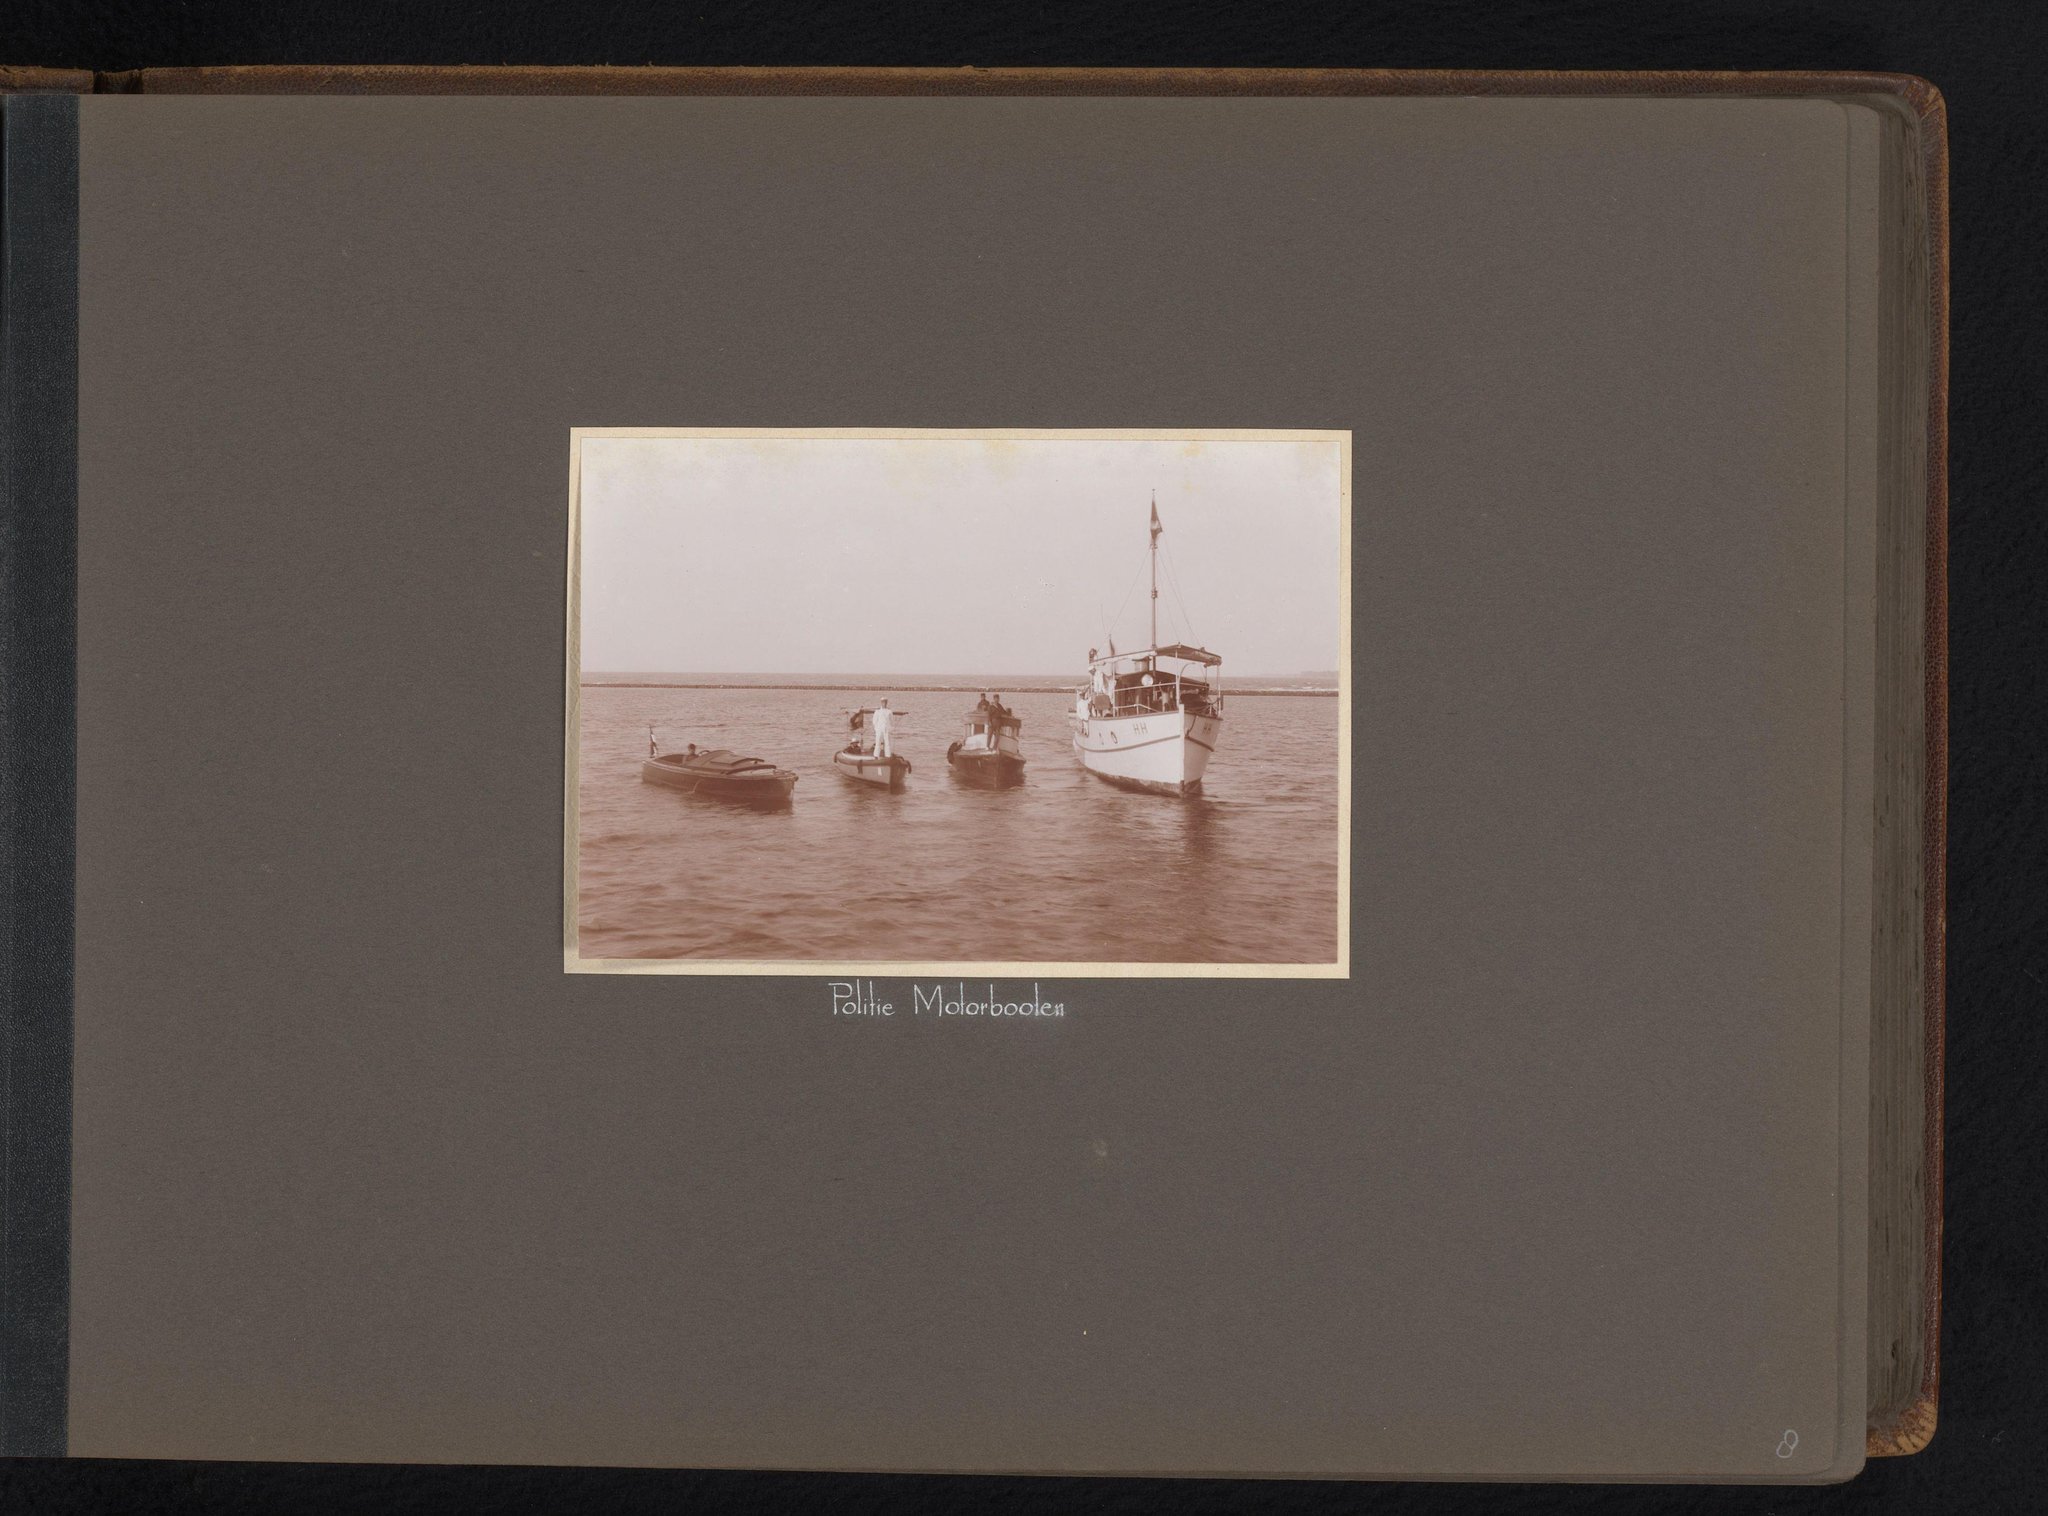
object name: album leaf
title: Politie Motorbooten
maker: Anonymous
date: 1925-1931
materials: cardboard, photographic support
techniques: collodion silver print, gelatin silver print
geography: batavia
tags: dutch east indies, the, batavia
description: Albumblad met één foto: vier verschillende typen motorboten in gebruik door te politie te Batavia. Onderdeel van het fotoalbum aangeboden aan S. Koster door de Vereeniging van Hoogere Politie Ambtenaren in Nederlandsch-Indië in 1931.